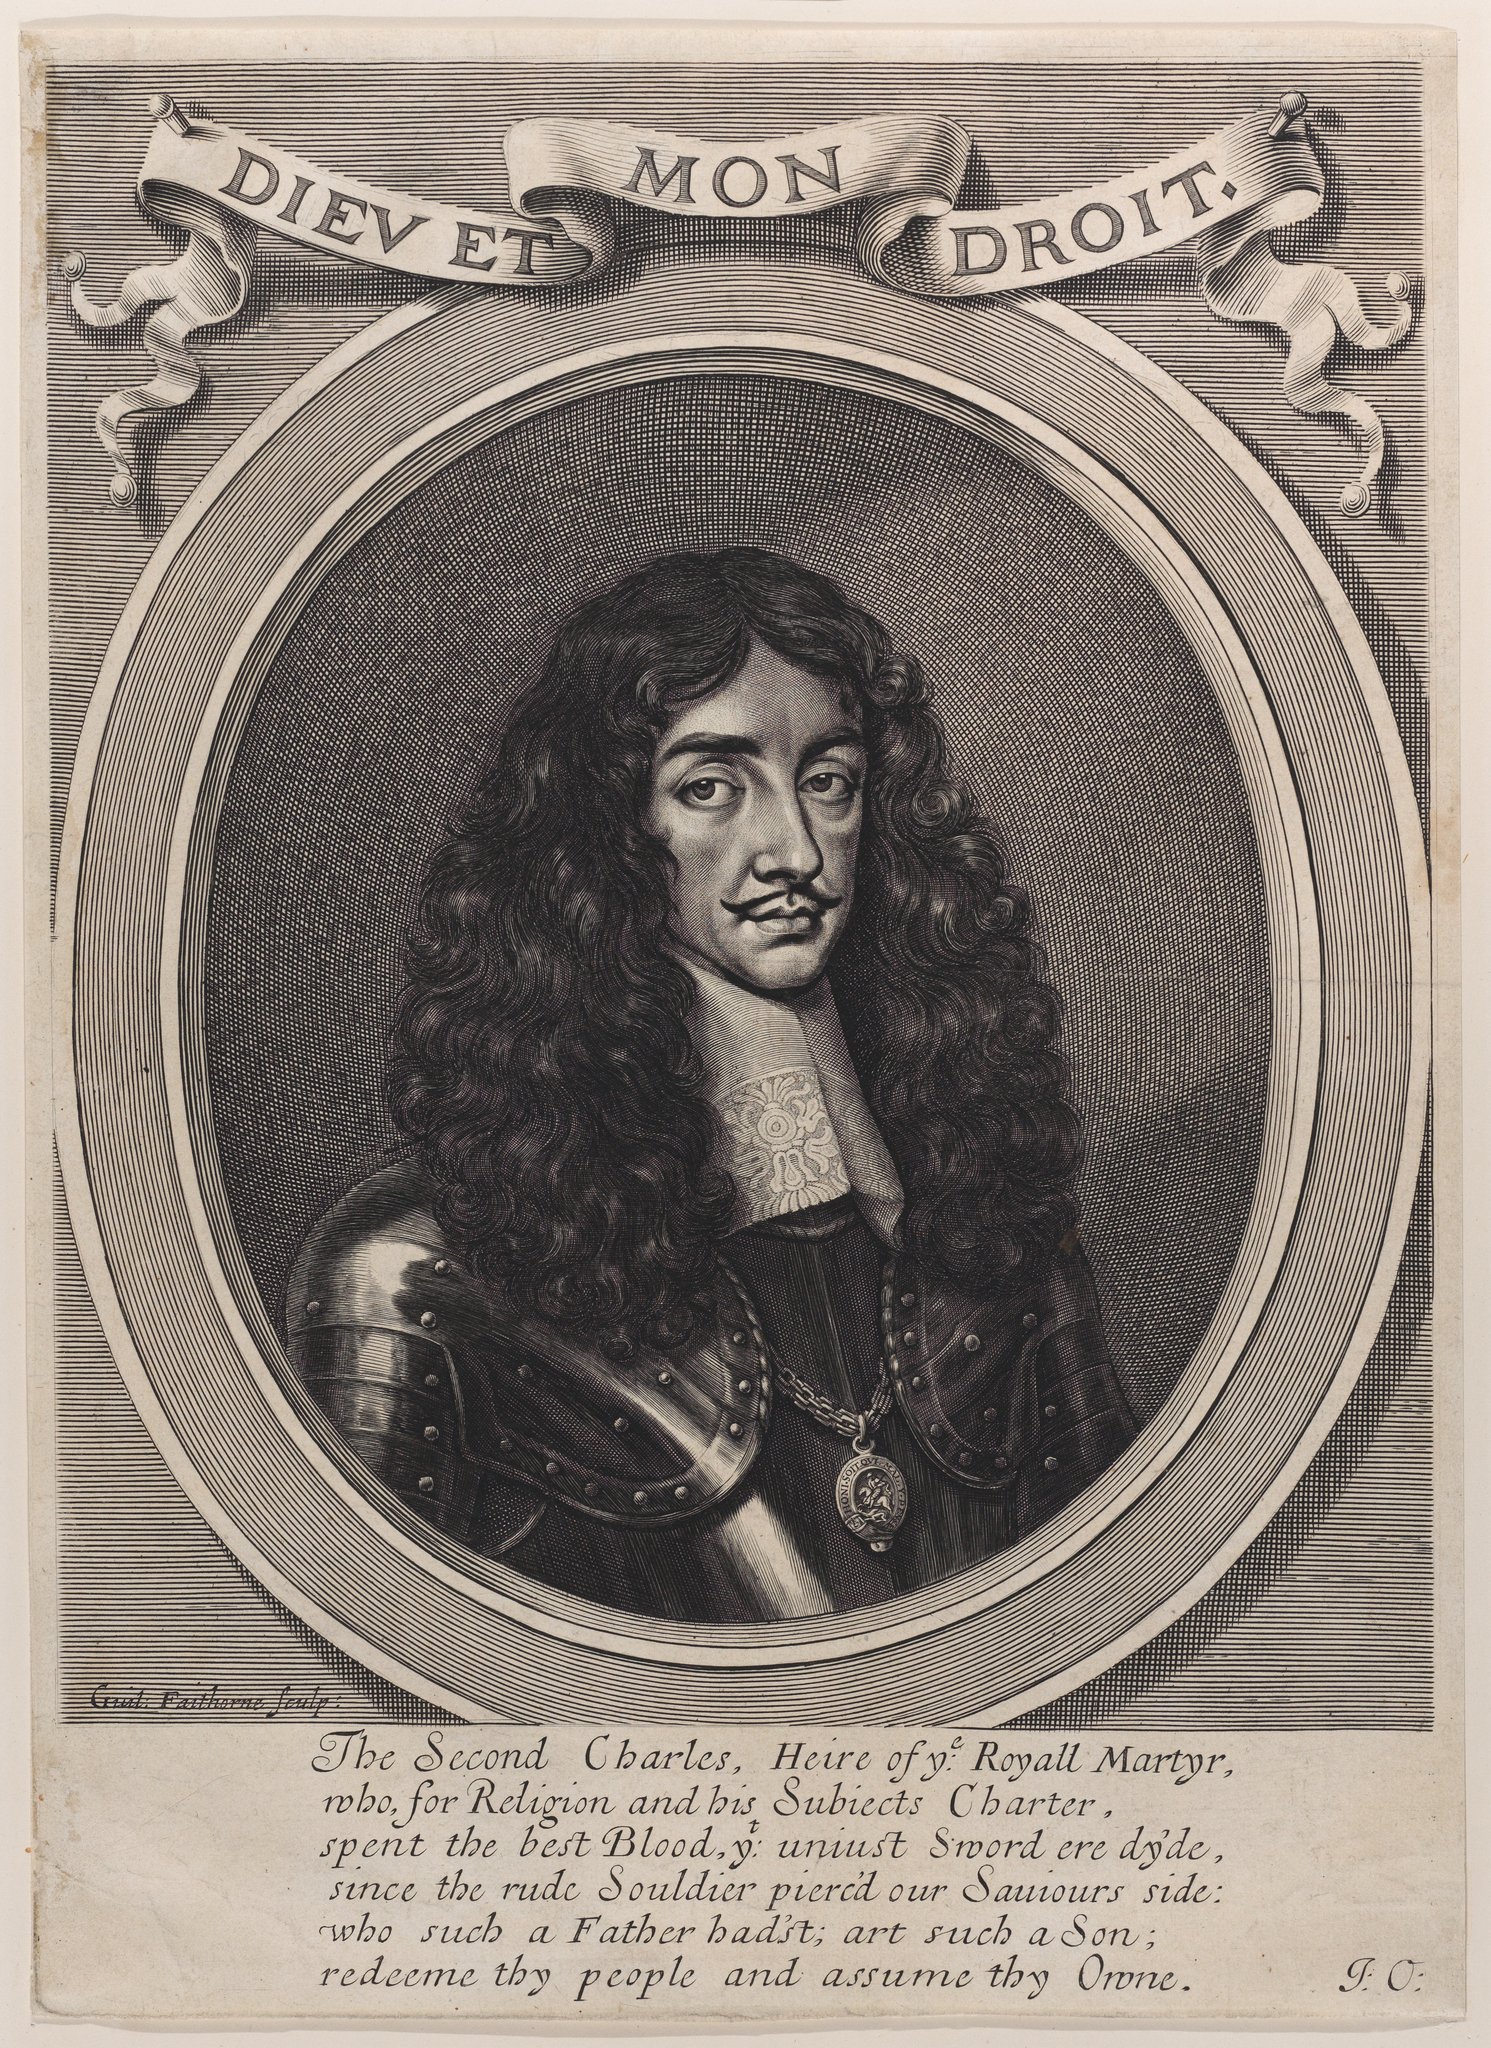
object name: print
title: King Charles II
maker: william faithorne the elder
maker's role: artist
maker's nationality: british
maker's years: 1615-1691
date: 1660-1670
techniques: engraving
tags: kings,men,portraits